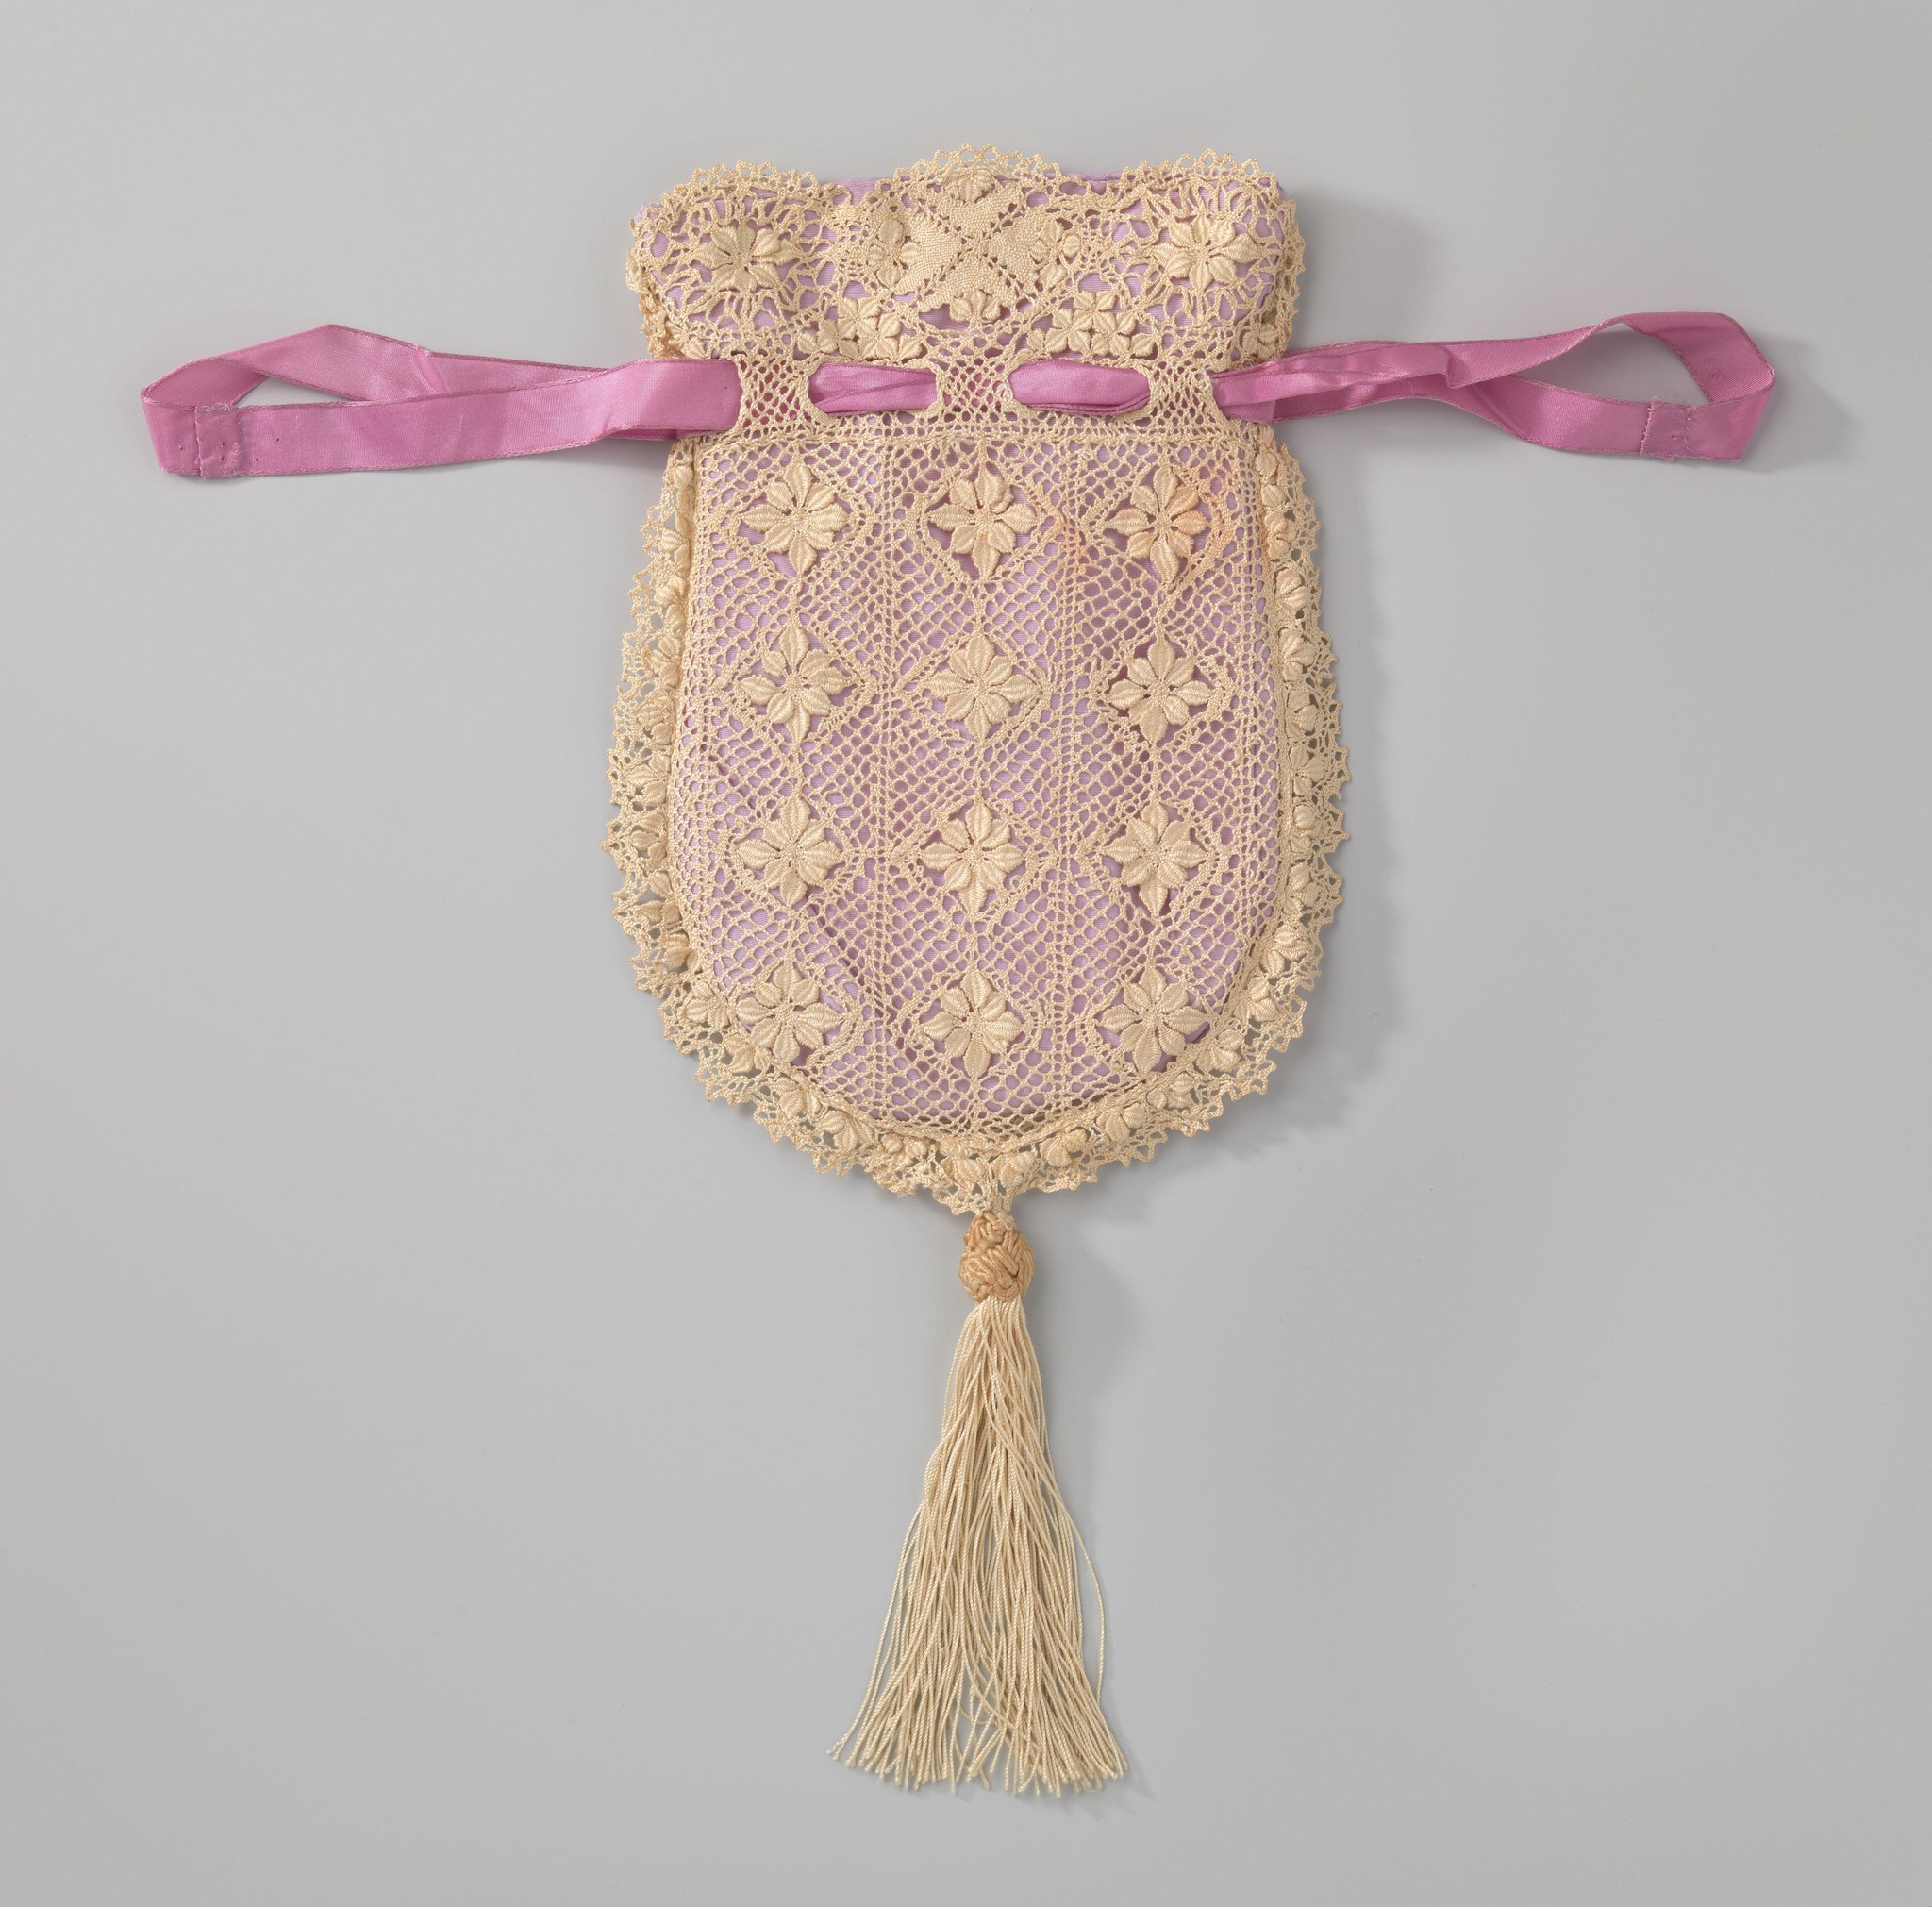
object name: reticule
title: Reticule in een afgeronde vorm van ecrukleurig kant bestaande uit een patroon van twaalf rozetten aan beide zijden, onderaan een kwast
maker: Anonymous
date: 1900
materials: silk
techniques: lace, weave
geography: malta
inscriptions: initials: ‘'CC'’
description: Reticule in een afgeronde vorm van ecrukleurig kant bestaande uit een patroon van twaalf rozetten, elk in een ruitmotief. De voor- en achterkant hebben hetzelfde patroon. Langs de bovenrand een baan van drie ovale medaillons, met in de middelste een Malteser kruis en vier kleine rozetten. Daaronder openingen voor een paarsroze rijglint van ripszijde. Onderaan de tas een kwast. De voering is van lichtpaarse kunstzijde.